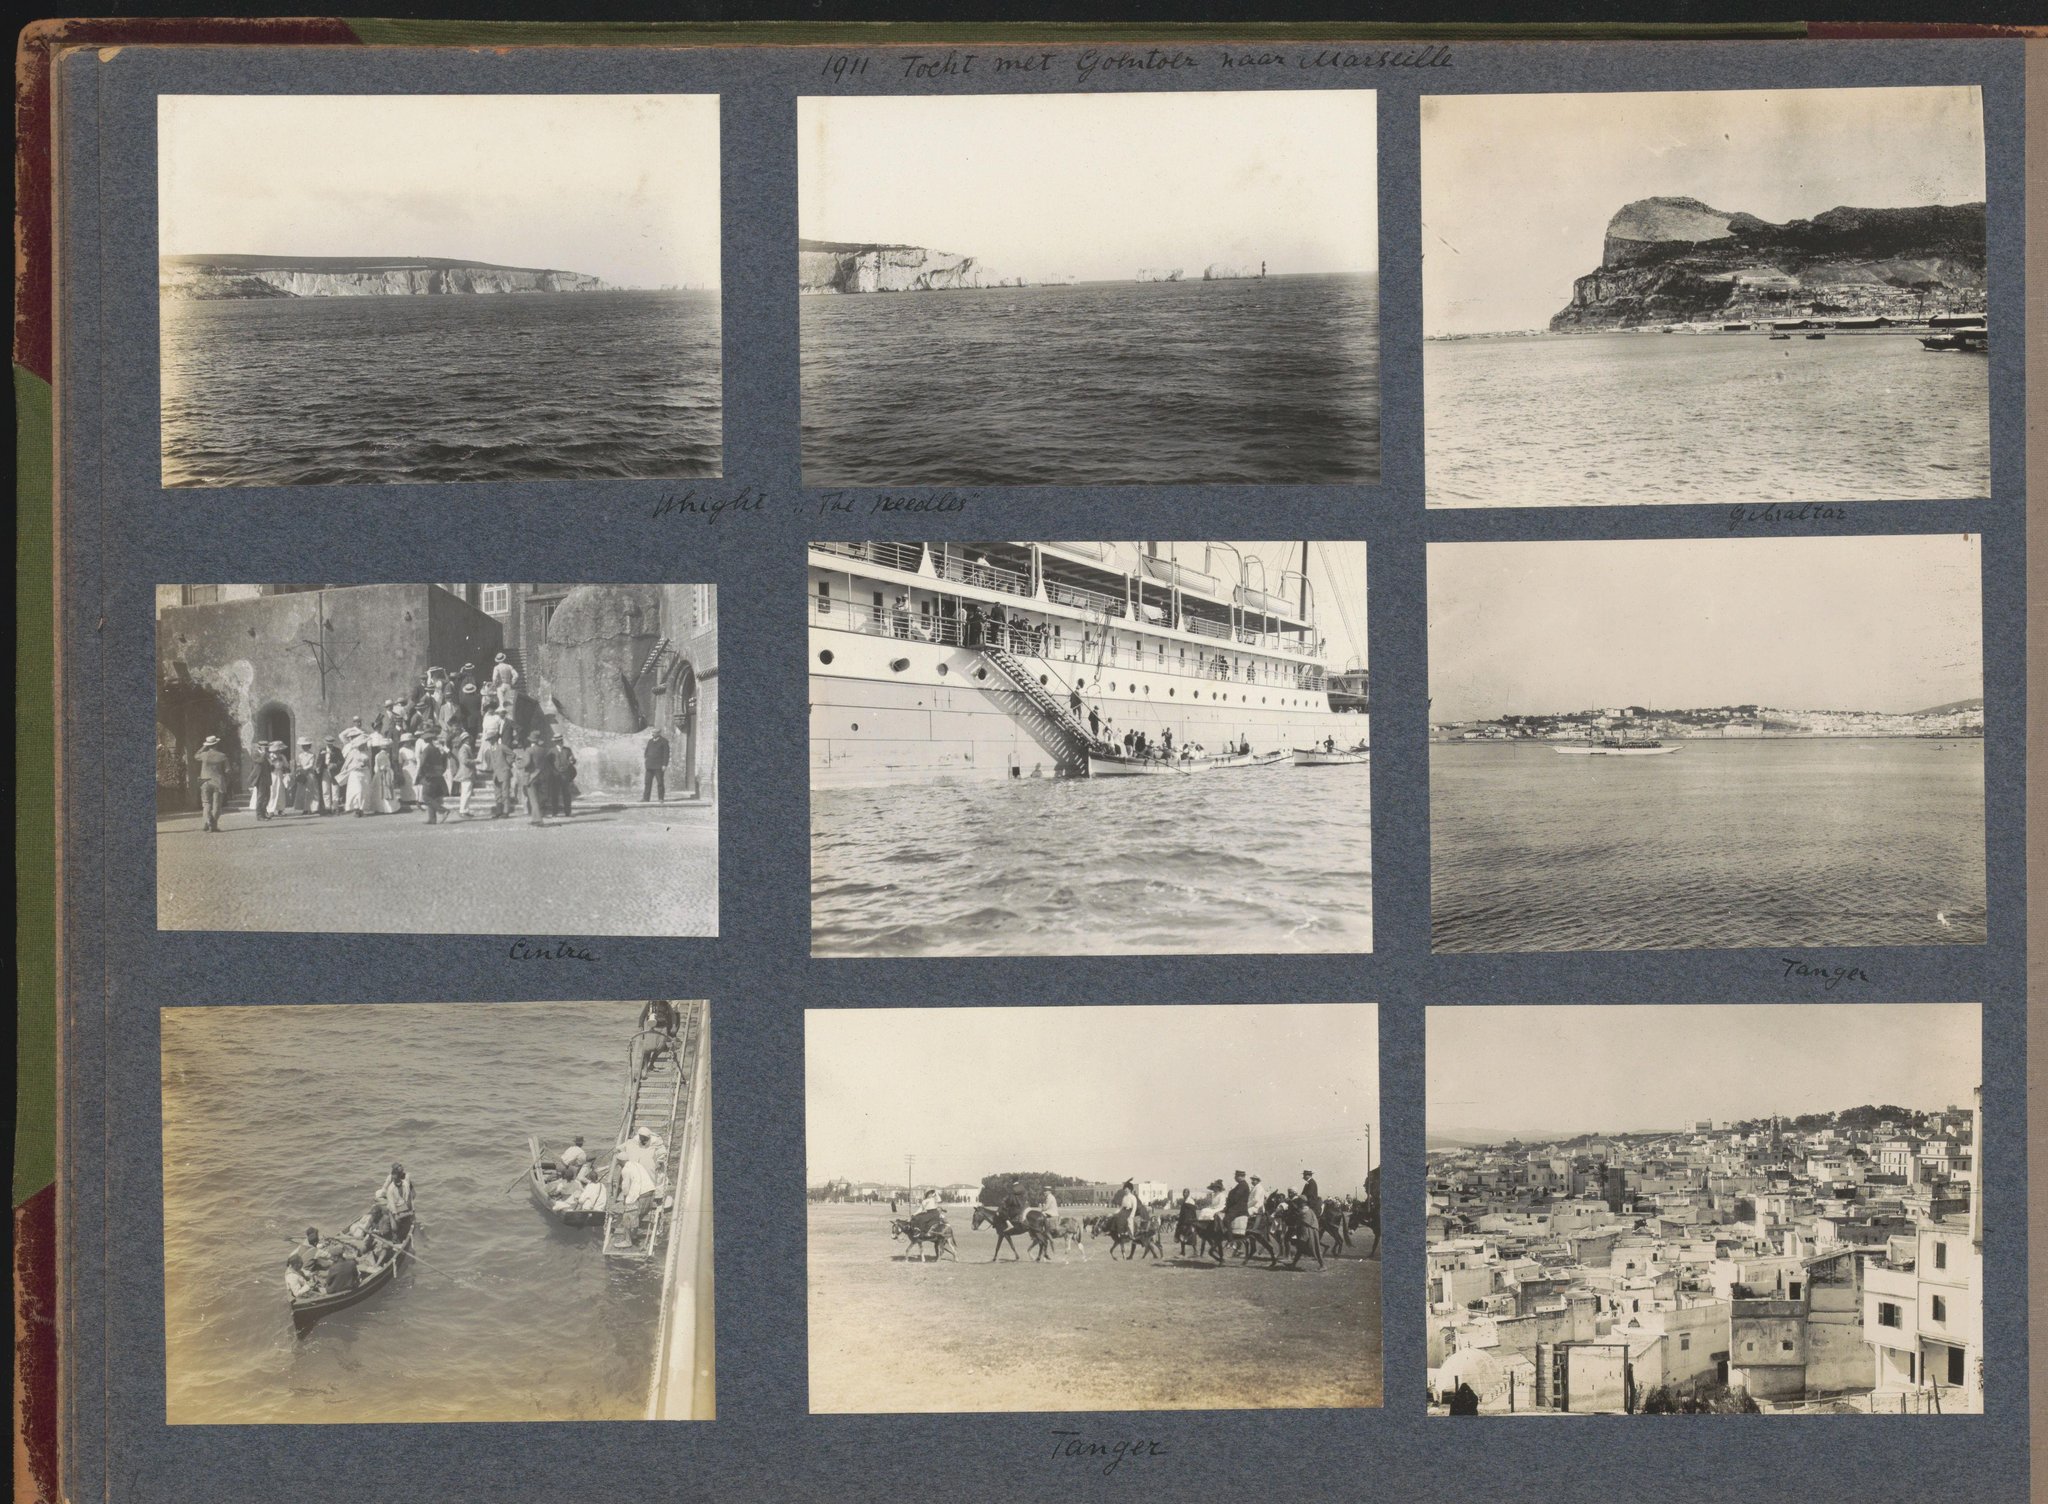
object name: photograph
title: Reis naar Isle of Wight, Gibraltar, Marseille, Sintra en Tanger (1)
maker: Anonymous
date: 1910-1911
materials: cardboard, paper, photographic support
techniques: gelatin silver print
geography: europe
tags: the family travelling, on holiday, travelling; tourism, prospect of city, town panorama, silhouette of city, steamship, motorship, marseille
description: Albumblad met negen foto's gemaakt tijdens een reis met het schip de 'Goentoer' naar diverse plaatsen: opnames van 'The Needles' bij het Isle of Wight, van de rots van Gibraltar, van een bezoek van een Europees reisgezelschap aan Sintra (Portugal), van een tocht in roeiboten, van een tocht op ezels en een stadsgezicht van Tanger. Onderdeel van Fotoalbum van de familie Palthe uit Almelo.